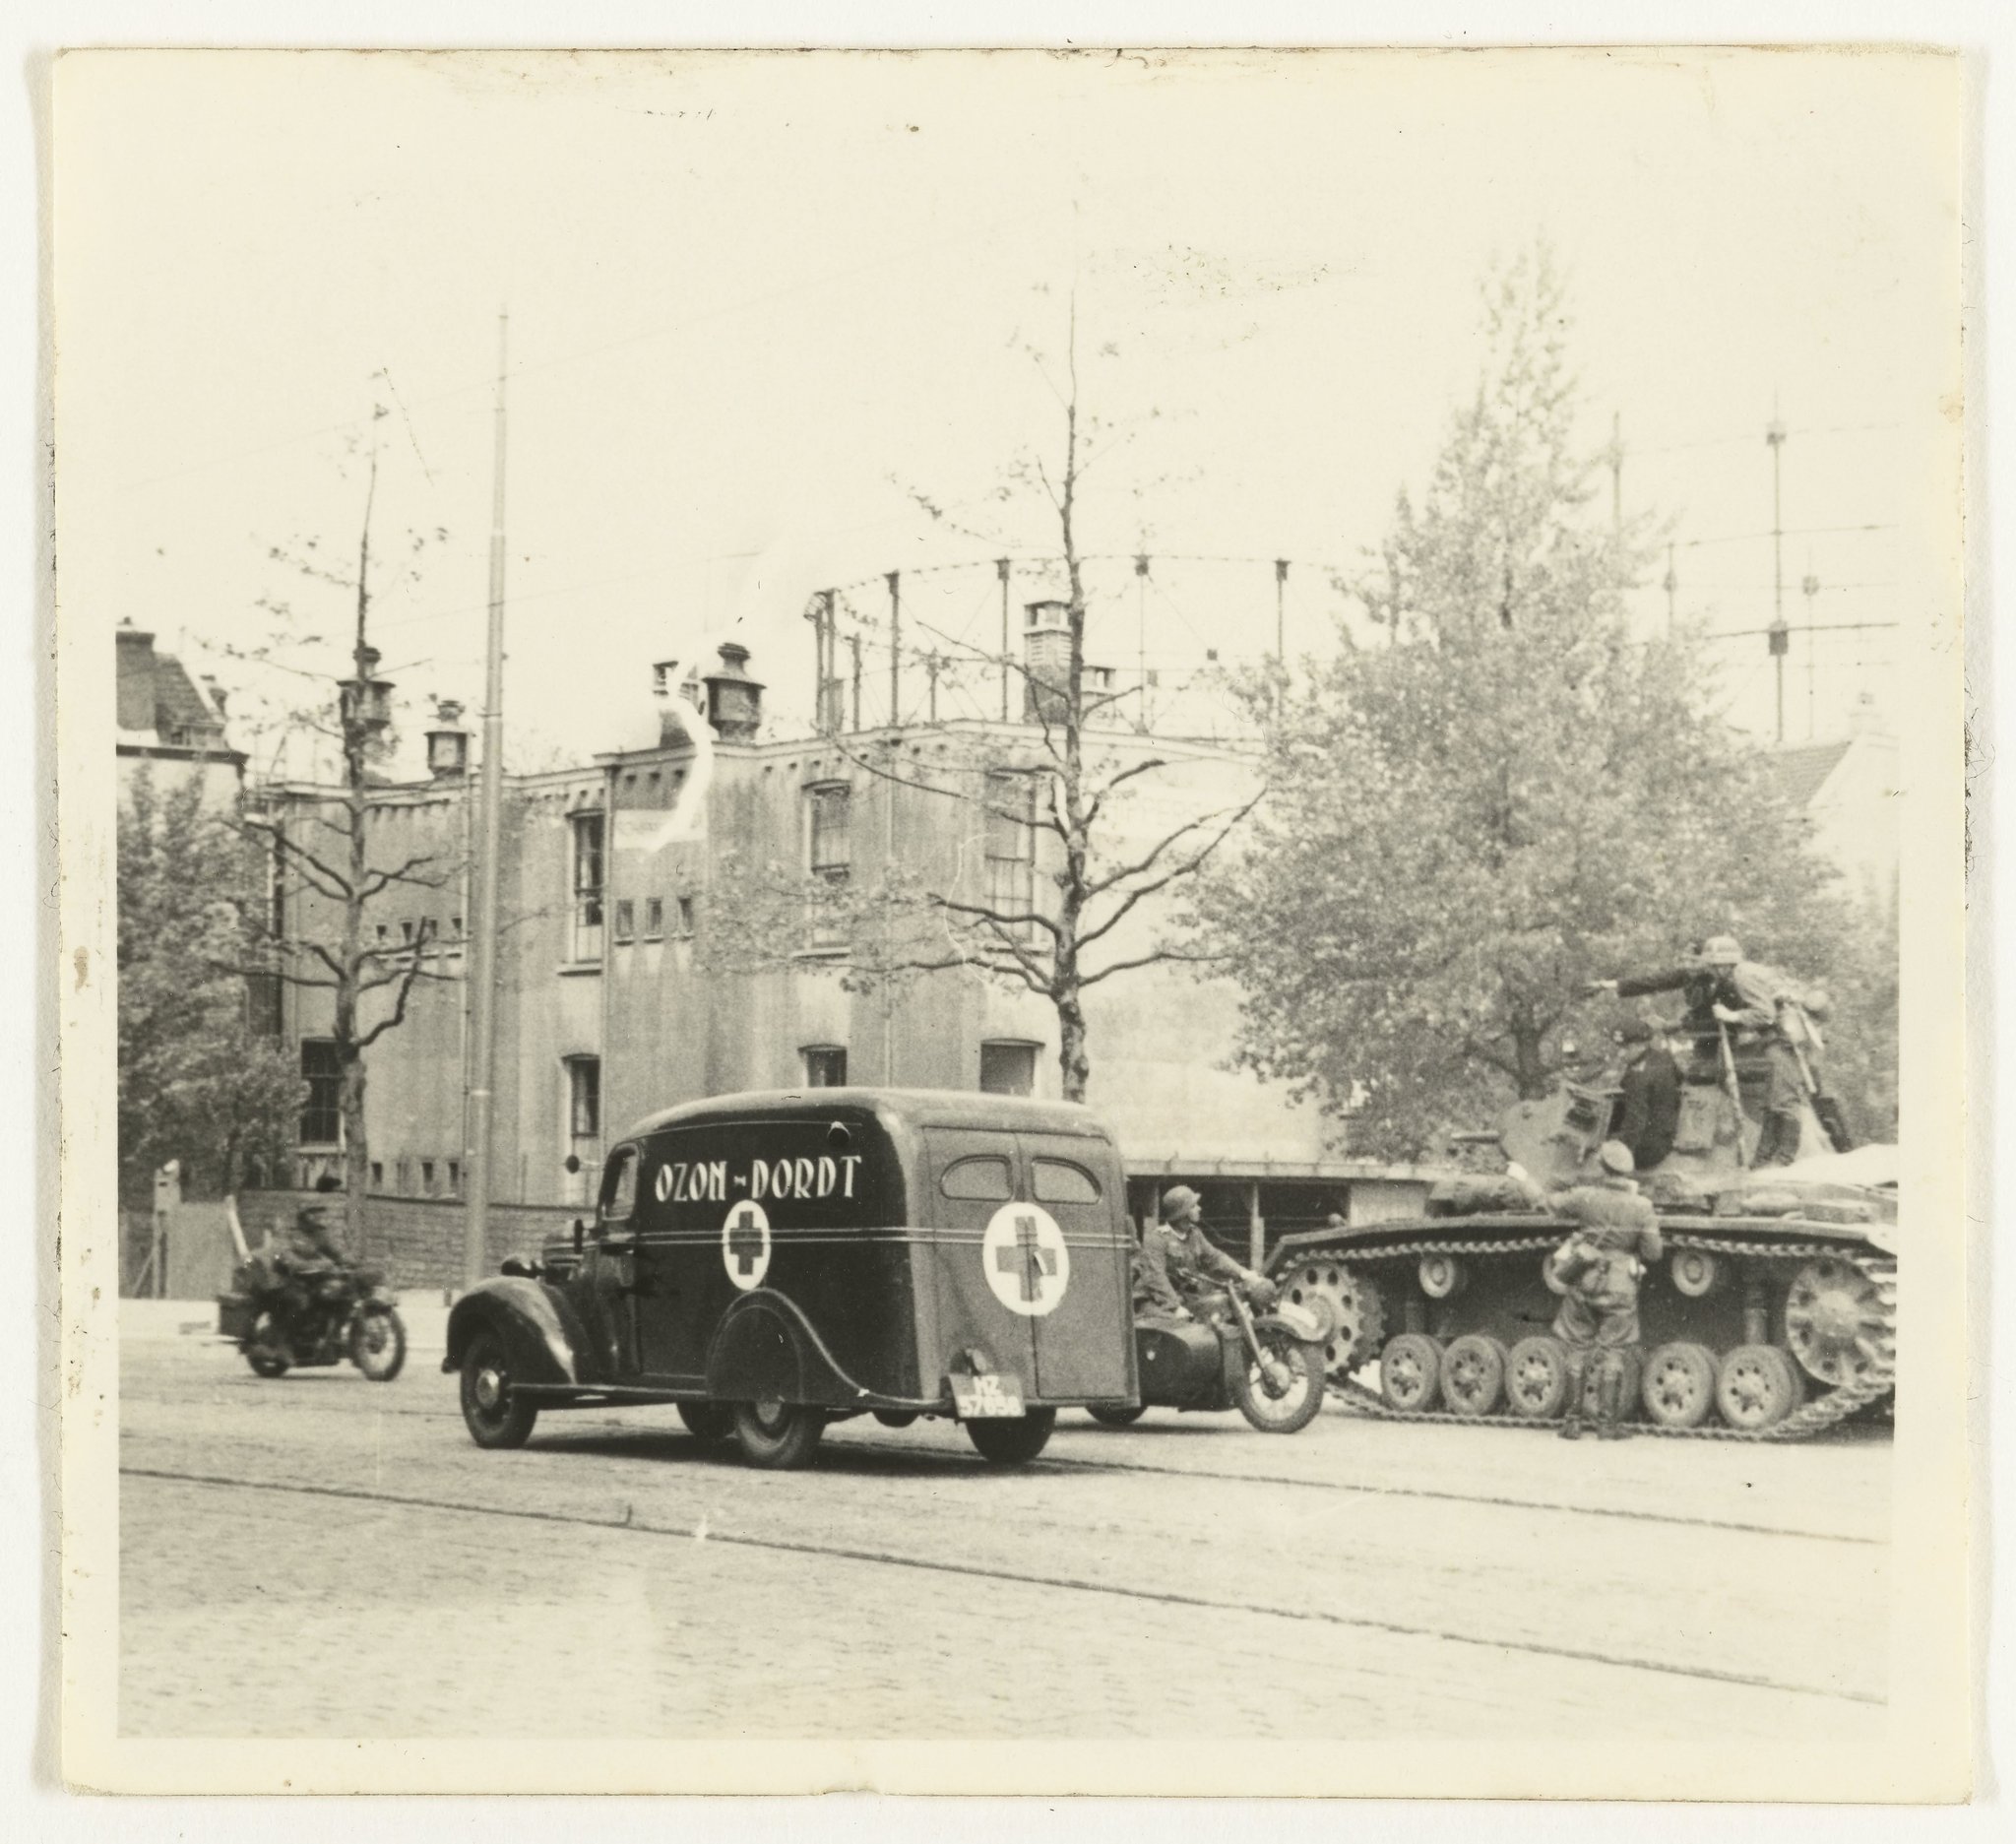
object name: photograph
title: Duitse tank en ambulance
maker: Anonymous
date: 1905-1940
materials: photographic support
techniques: gelatin silver print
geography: dordrecht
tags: ambulance, modern forms of military vehicles (tank), occupation ~ war, dordrecht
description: In een straat staat een tank met Duitse soldaten, infanteristen, er op en er naast. Naast de tank een Duitse soldaat op een motor met zijspan, een motorordonnans. Links van de tank een ambulance met het opschrift: Ozon-Dordt en een nummerbord met NZ. Voor de ambulance rijdt een Duitse soldaat op een motorfiets. Op de achtergrond zijn twee gashouders te zien.